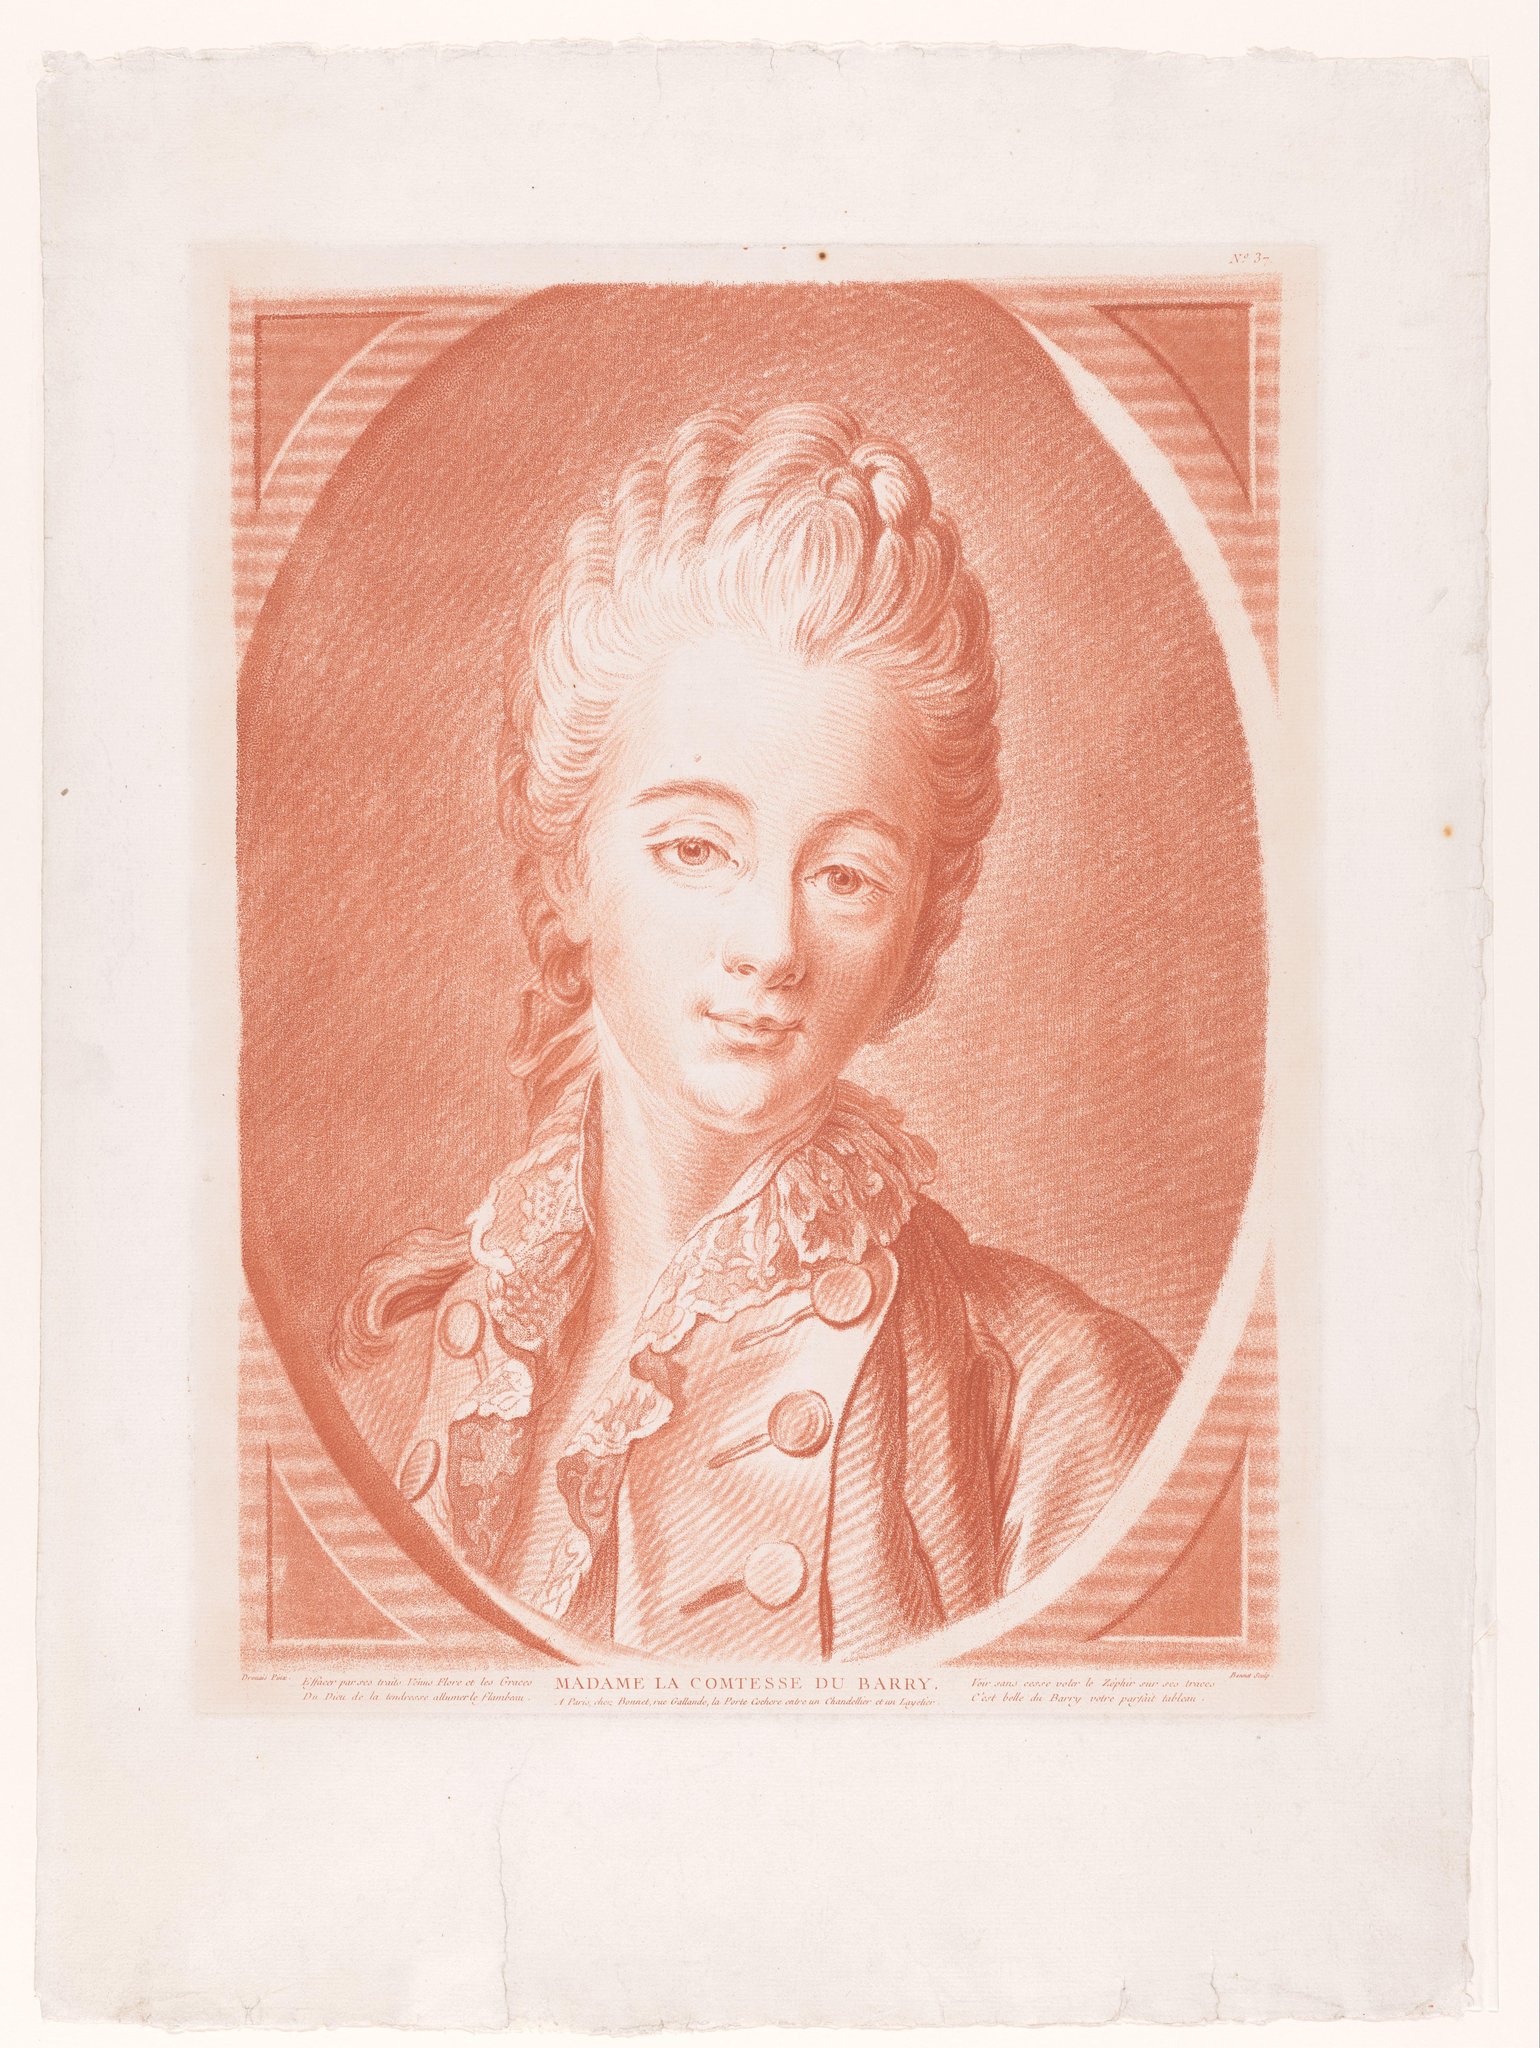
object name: print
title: Portrait of Madame du Barry in a Hunting Costume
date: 1760-1793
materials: paper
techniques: printmaking, engraving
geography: paris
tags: paris, historical persons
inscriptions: collector's mark: Lugt 2760, collector's mark: Lugt 2228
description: Kings’ mistresses have always enjoyed a special status in France, as unofficial counsellors and patrons of the arts. The Comtesse du Barry, Louis XV’s last mistress, spent a lot of money on art as well. Her likeness by Drouais became so popular that Bonnet reproduced it in ‘crayon manner’, a printmaking technique that had just been patented, here imitating a luscious red chalk drawing.